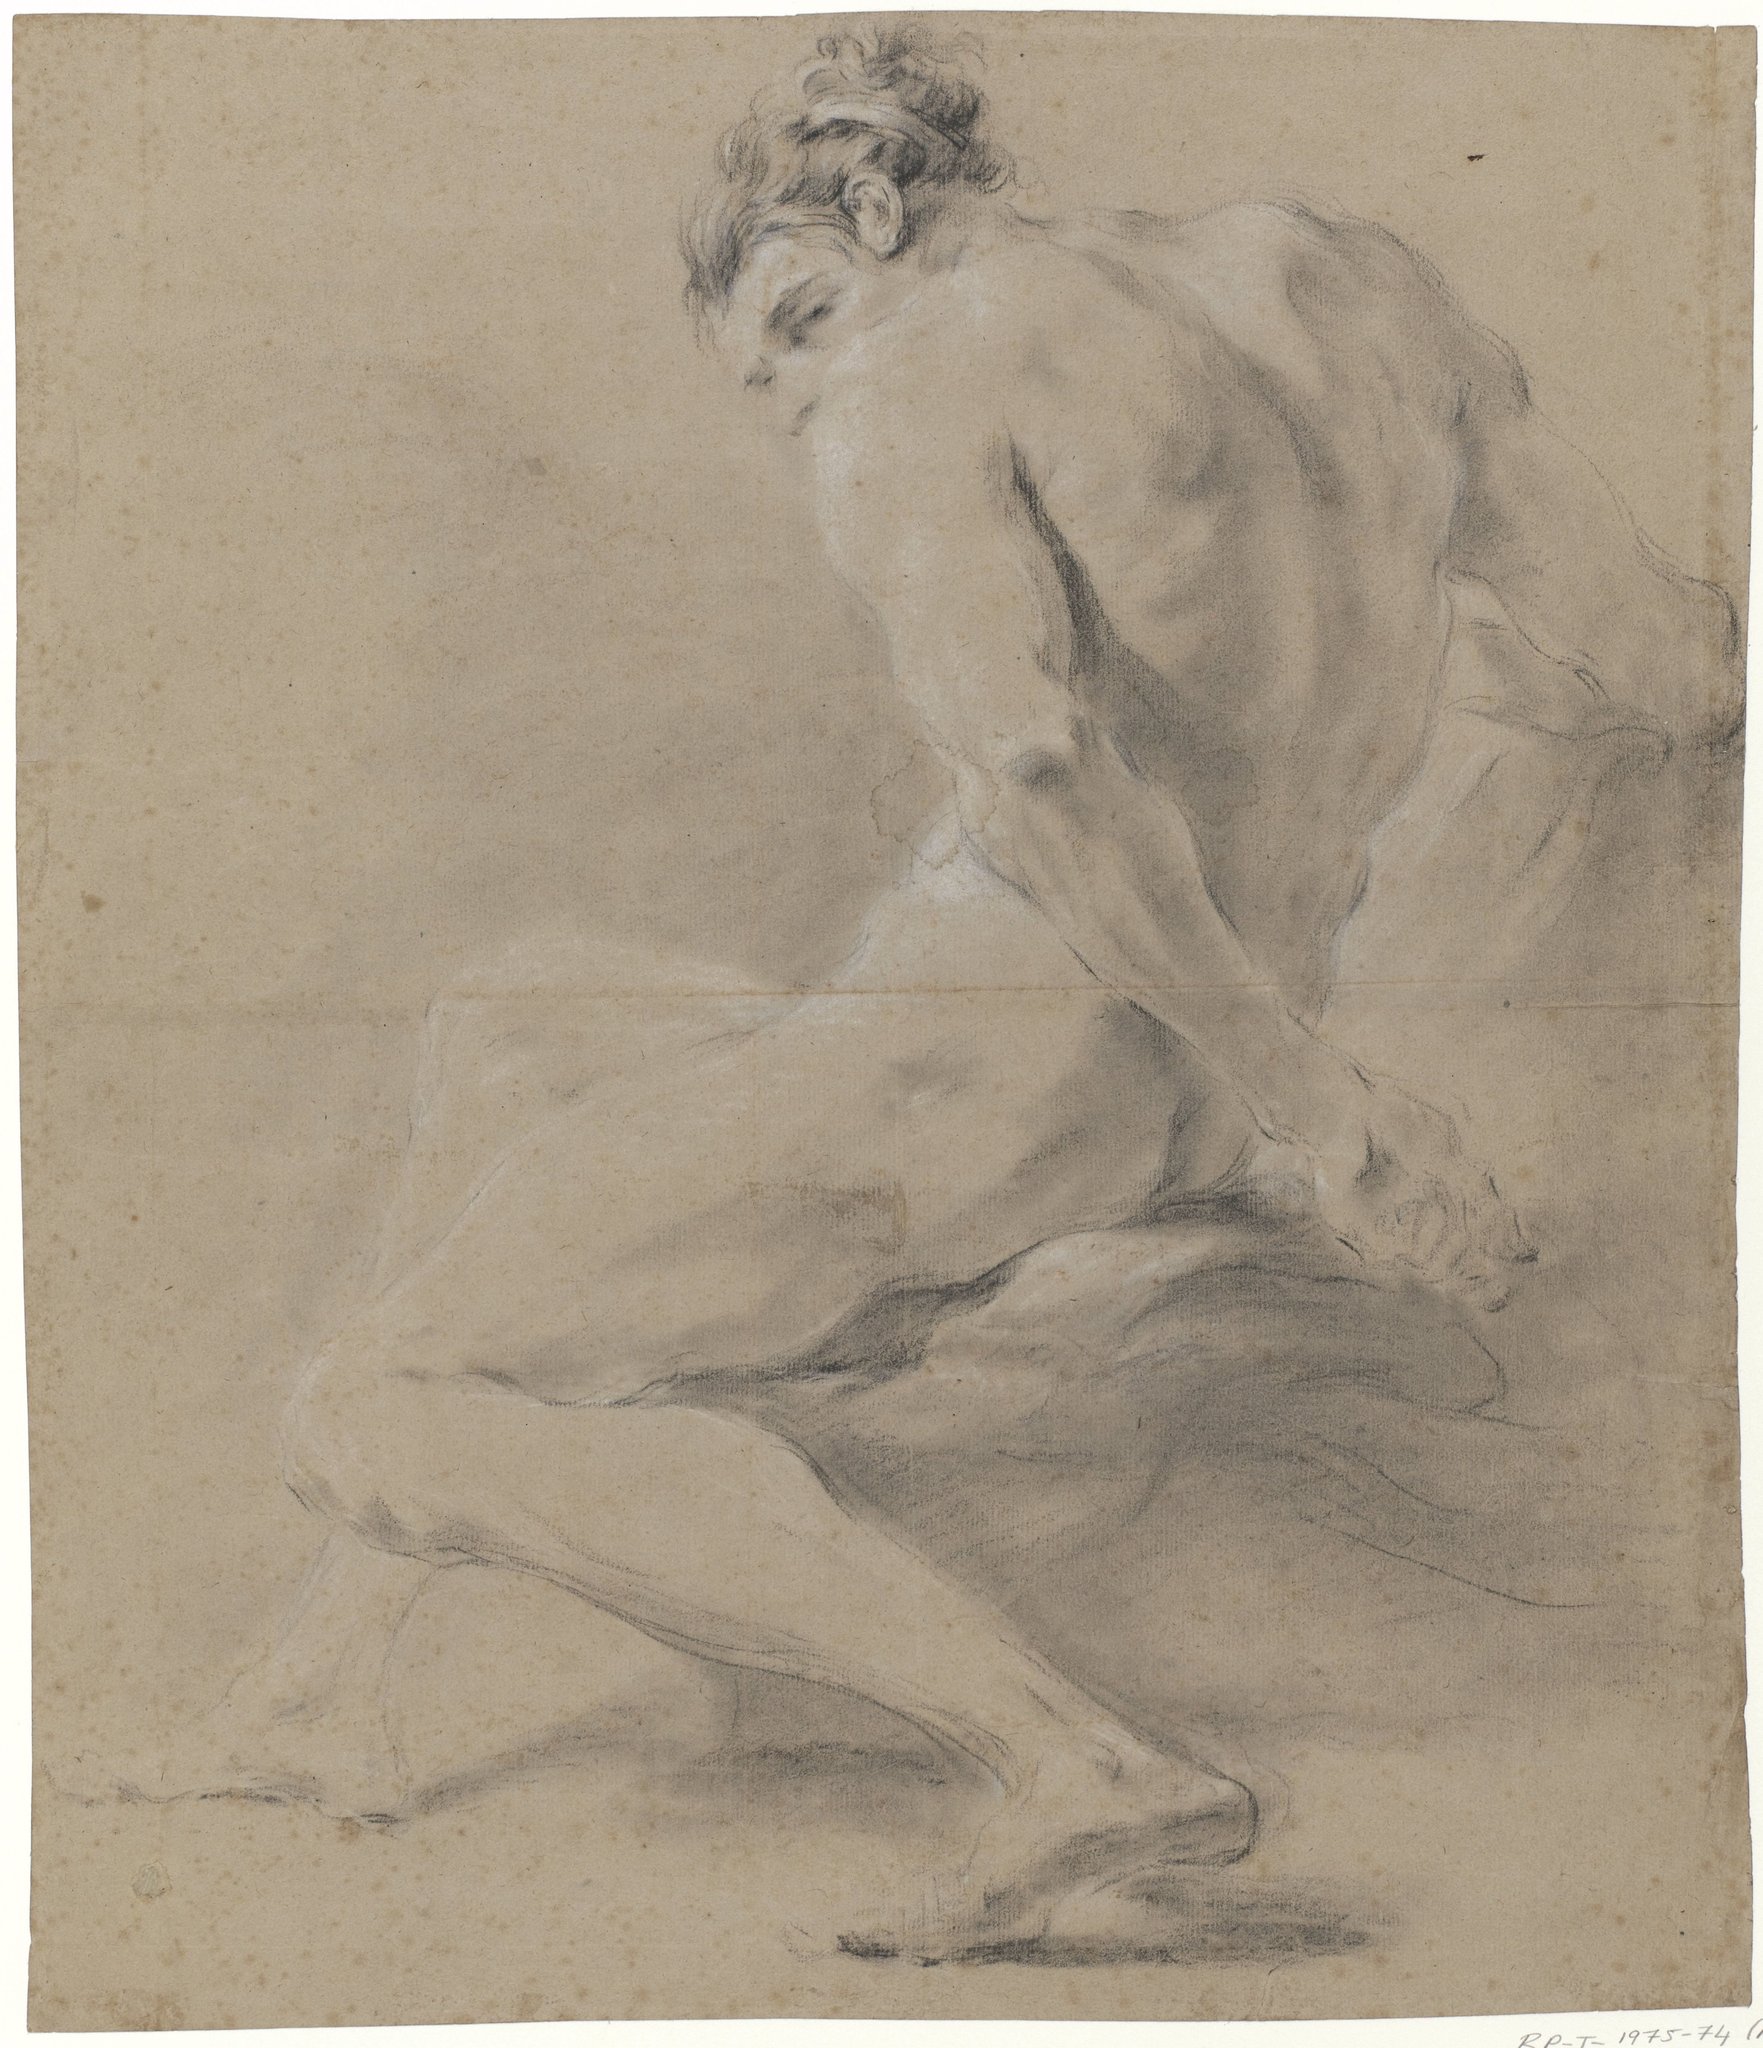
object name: drawing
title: Zittend mannelijk naakt, het hoofd steunend met de rechterhand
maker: jan willem pieneman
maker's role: draughtsman, painter, print maker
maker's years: 1779-1853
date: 1789-1853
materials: chalk, paper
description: Zittend mannelijk naakt, het hoofd steunend met de rechterhand, de linkerarm wijzend opgeheven.